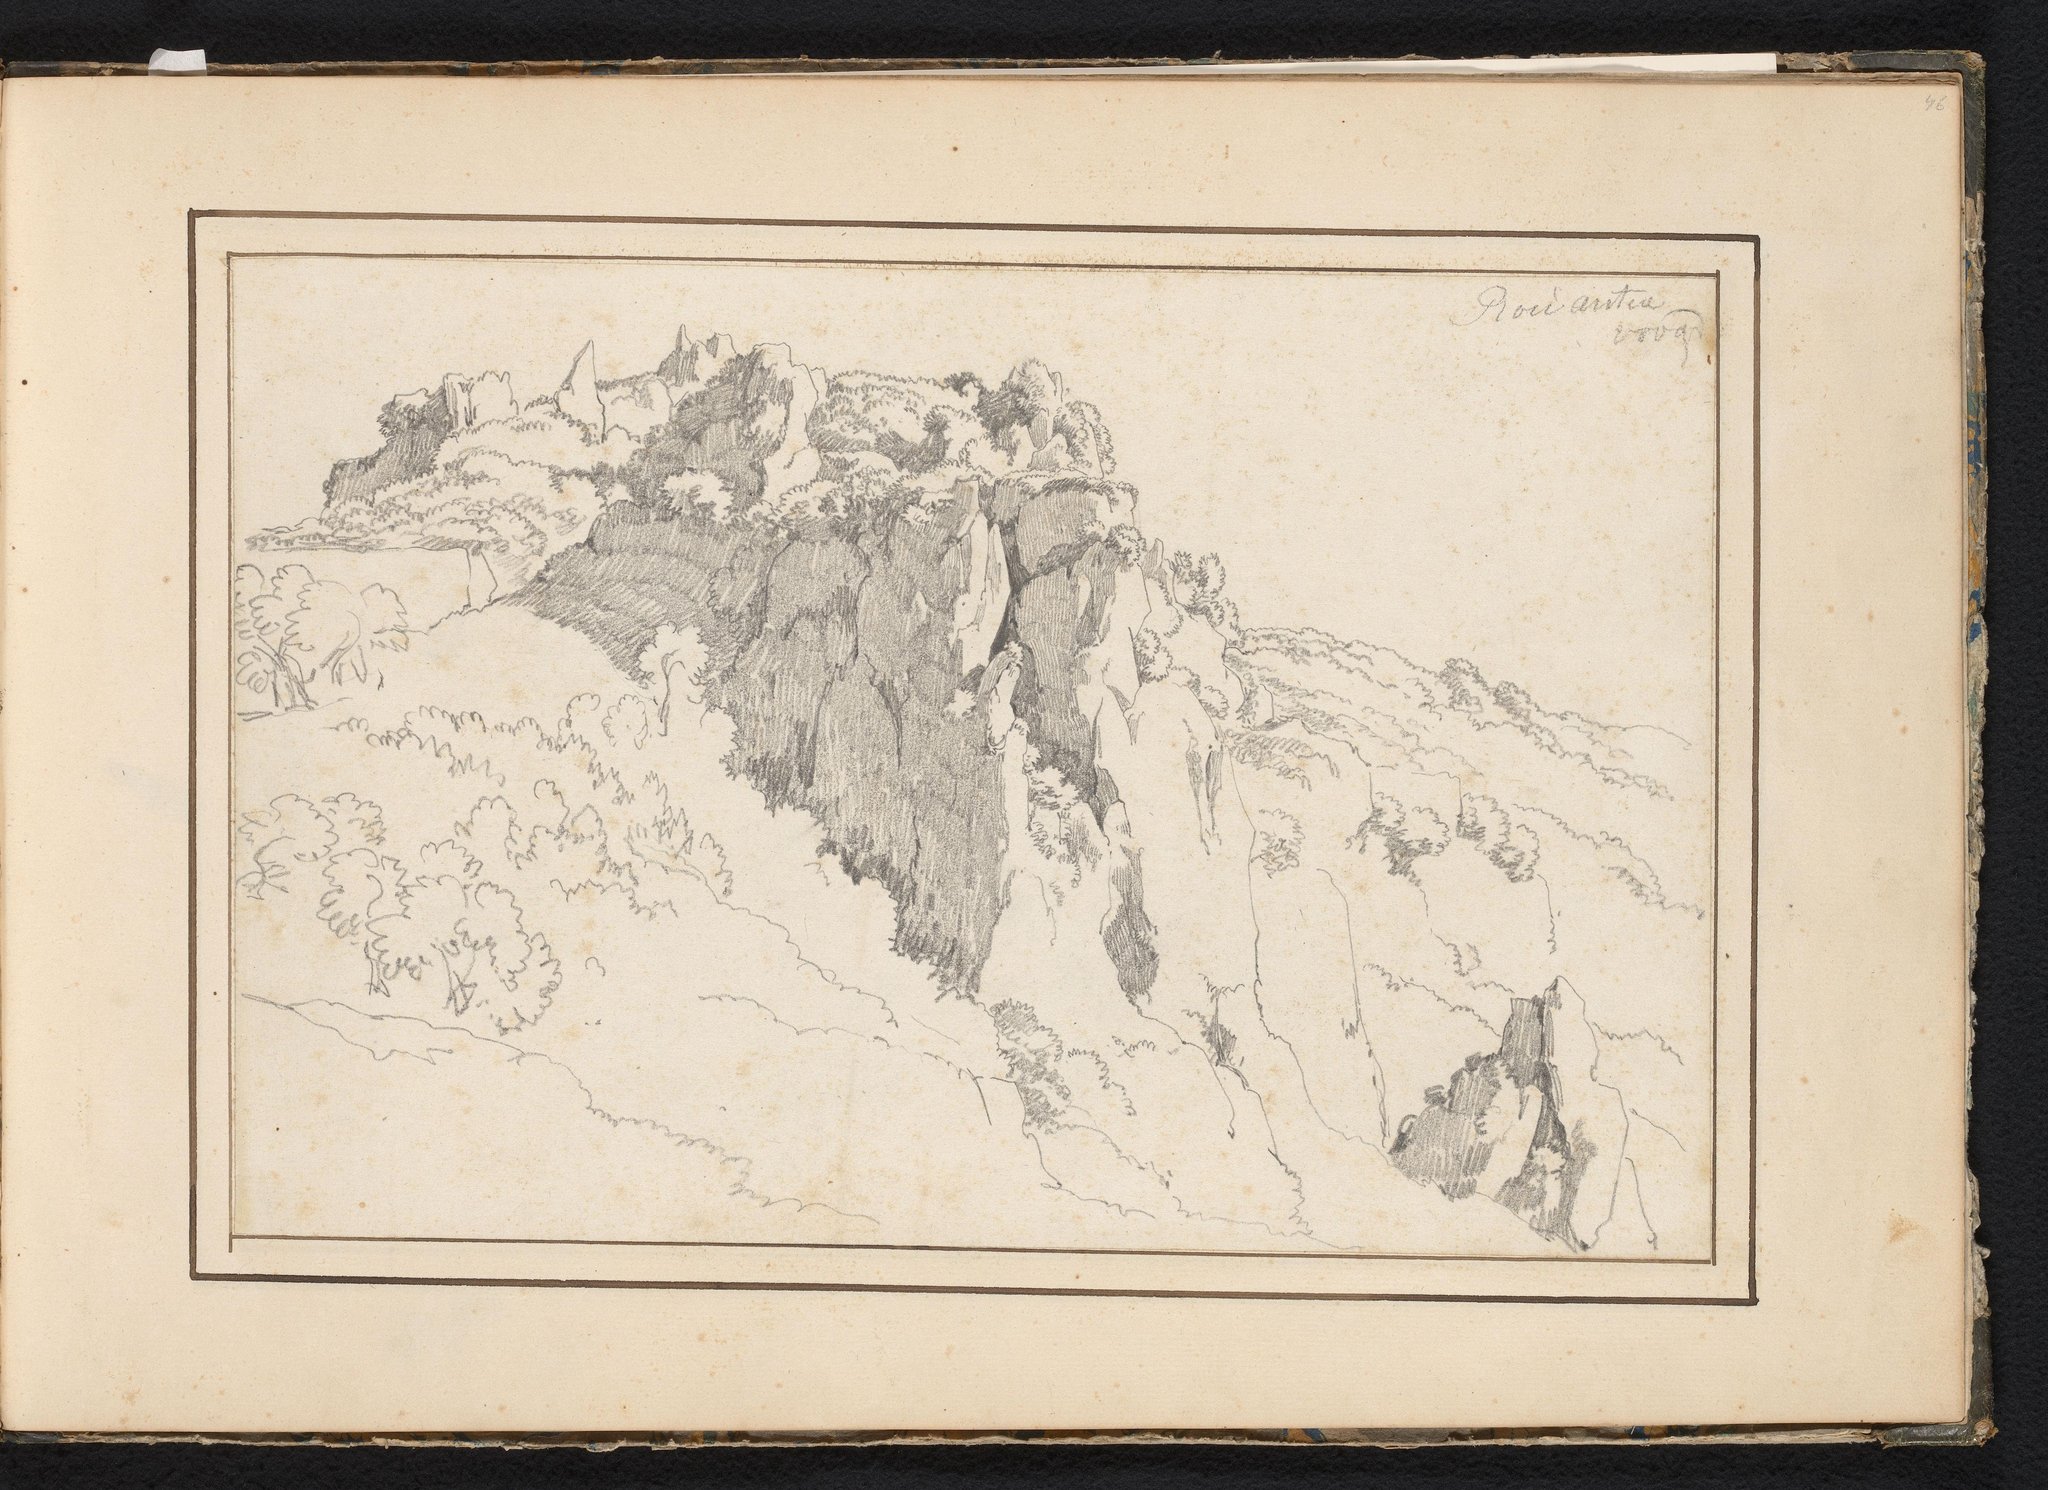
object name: album leaf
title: Berglandschap te Roccantica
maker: hendrik voogd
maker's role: draughtsman, painter, print maker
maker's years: 1768-1839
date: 1788-1839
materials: paper, pencil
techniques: pasting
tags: landscapes, mountains, roccantica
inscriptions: inscription: ‘Rocc'antica’